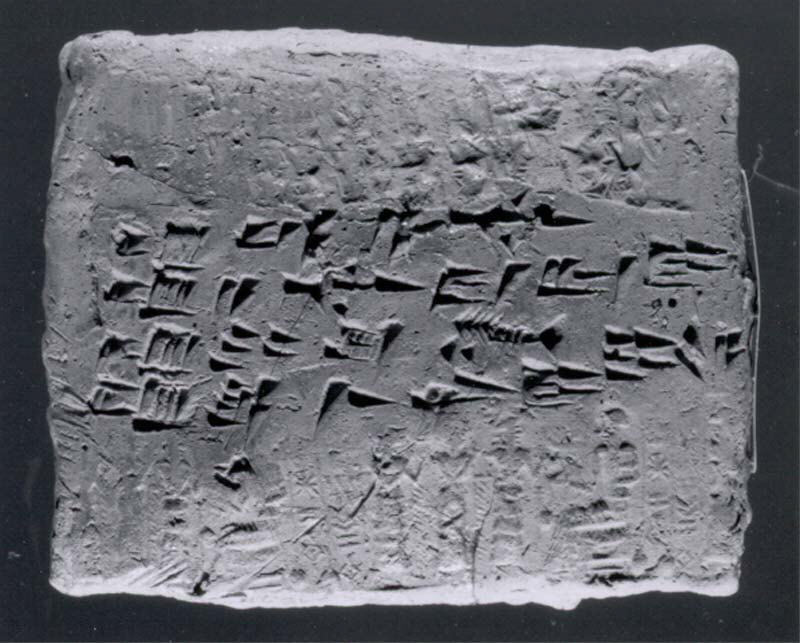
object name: cuneiform tablet case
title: Cuneiform tablet case impressed with five cylinder seals, for cuneiform tablet 66.245.21b: court deposition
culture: assyrian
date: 2000-1801 BCE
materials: clay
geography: anatolia